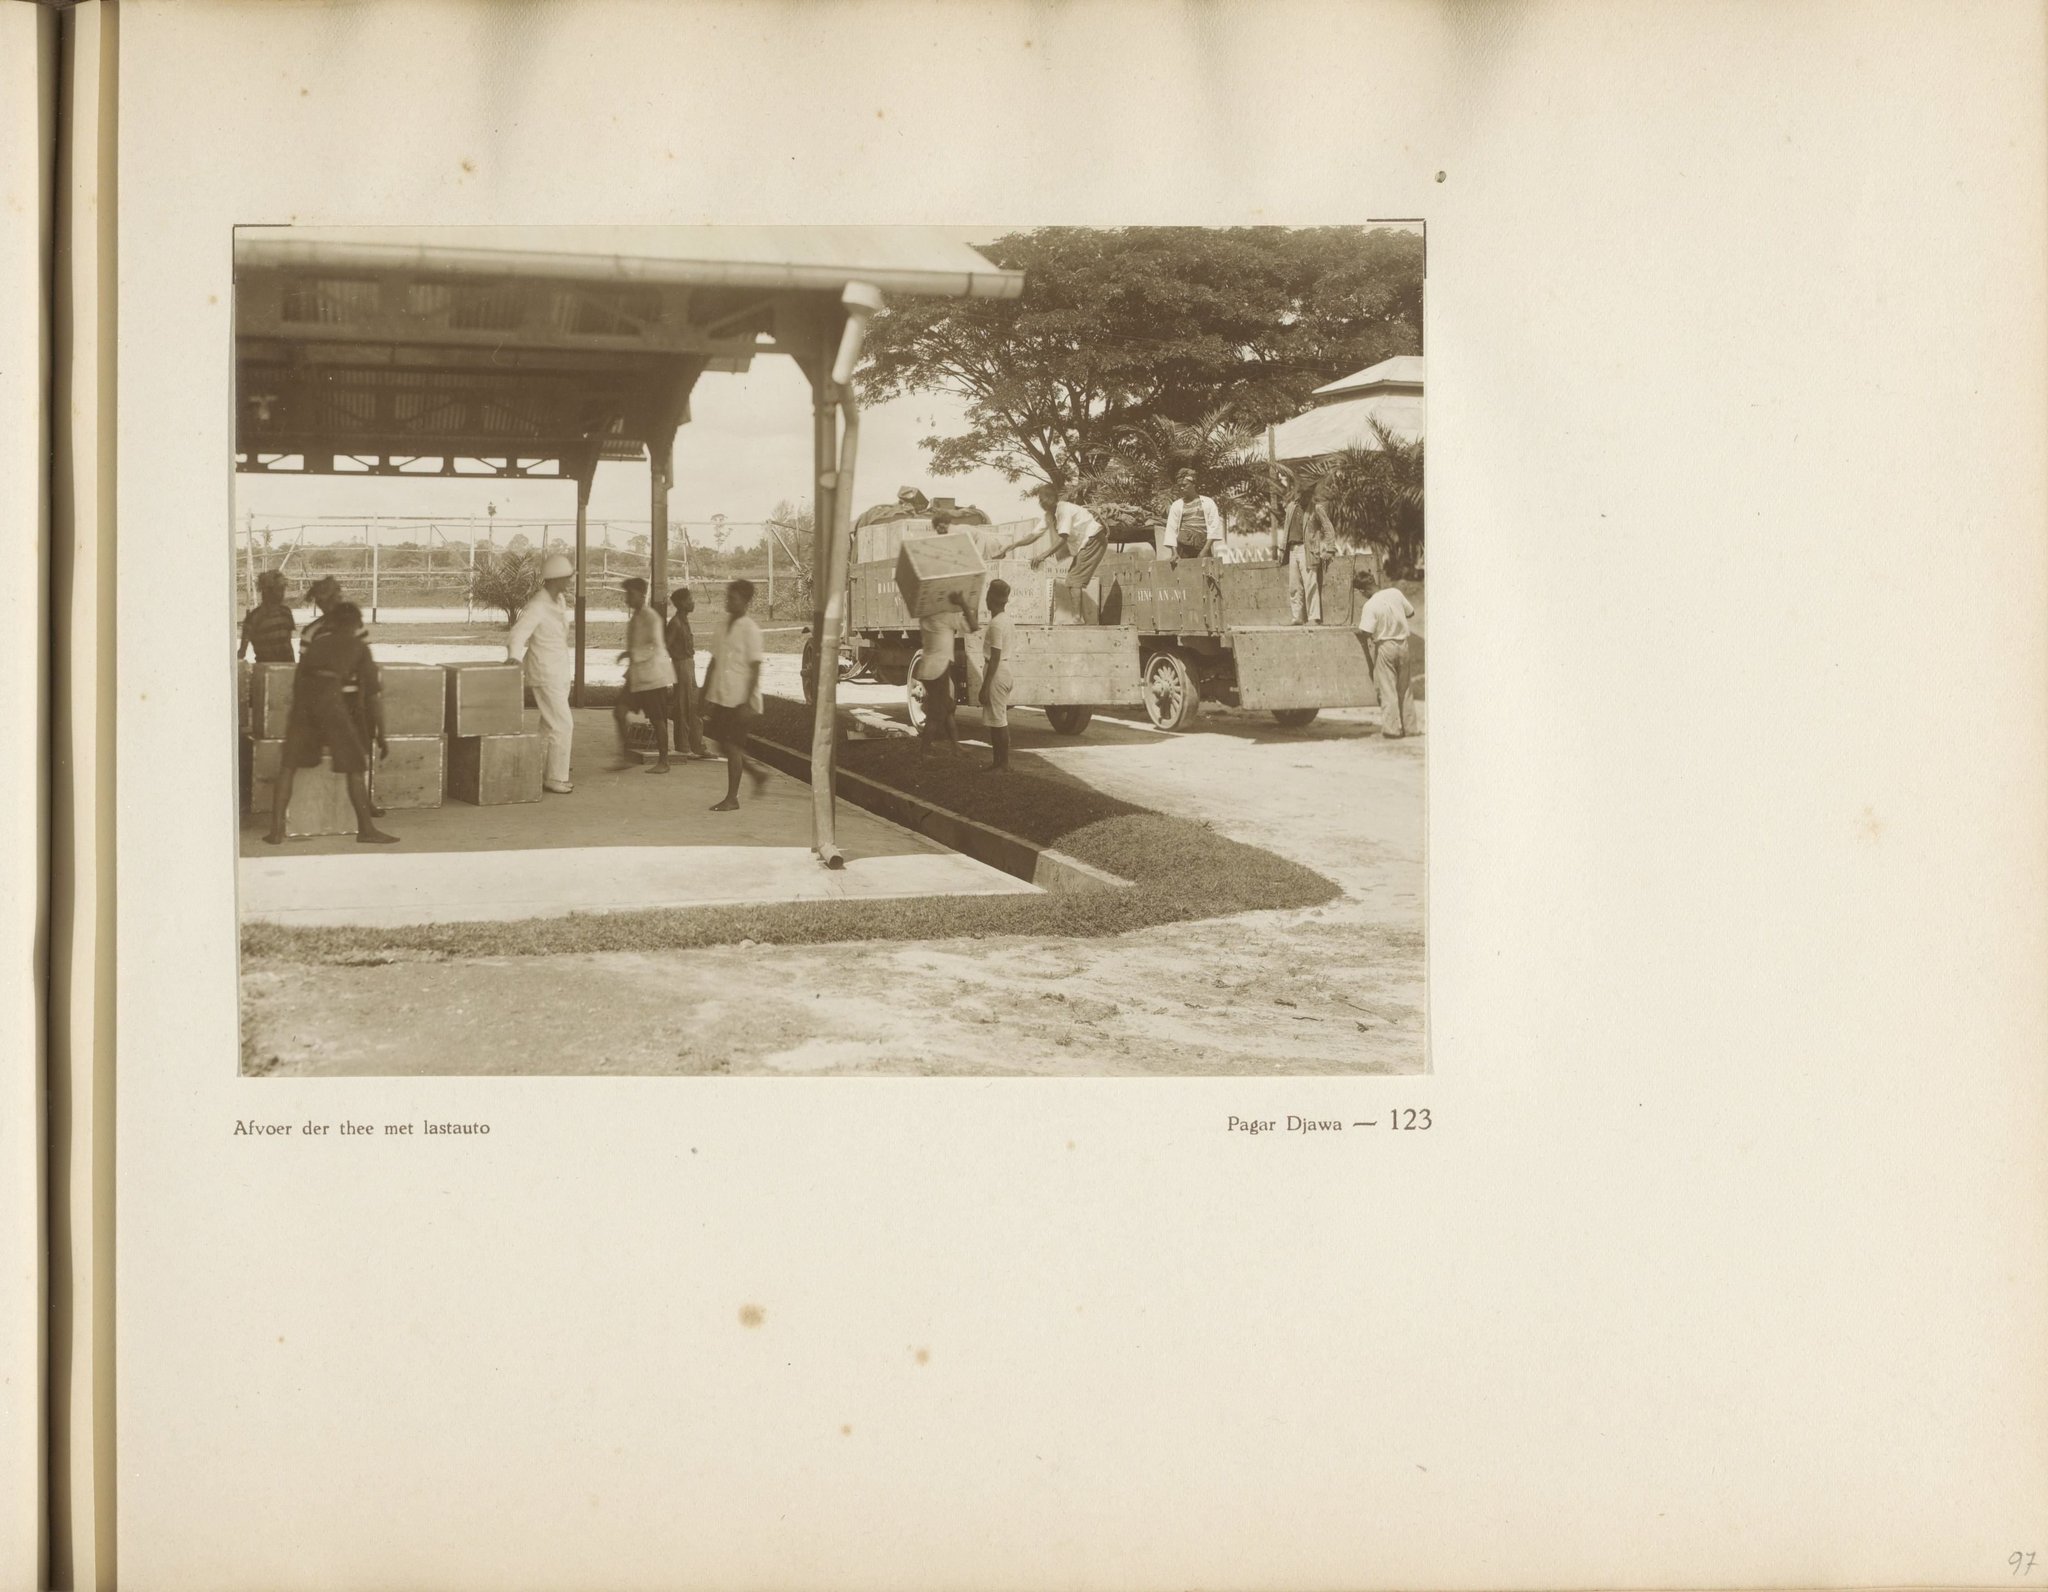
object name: photograph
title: Pagina 123 van fotoboek van de Algemeene Vereeniging van Rubberplanters ter Oostkust van Sumatra (A.V.R.O.S.)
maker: j.w. meyster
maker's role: fotograaf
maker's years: 1887-1945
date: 1924-1925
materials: paper, photographic support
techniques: printing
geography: sumatra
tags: truck, van, (non-fruit) products of plants or trees: rubber, working class, labourers, sumatra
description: Boekpagina met een foto van Indische werkkrachten die thee op vrachtwagens laden bij een theefabriek te Pagar Djawa. Onderdeel van een fotoboek van de Algemeene Vereeniging van Rubberplanters ter Oostkust van Sumatra (A.V.R.O.S.).